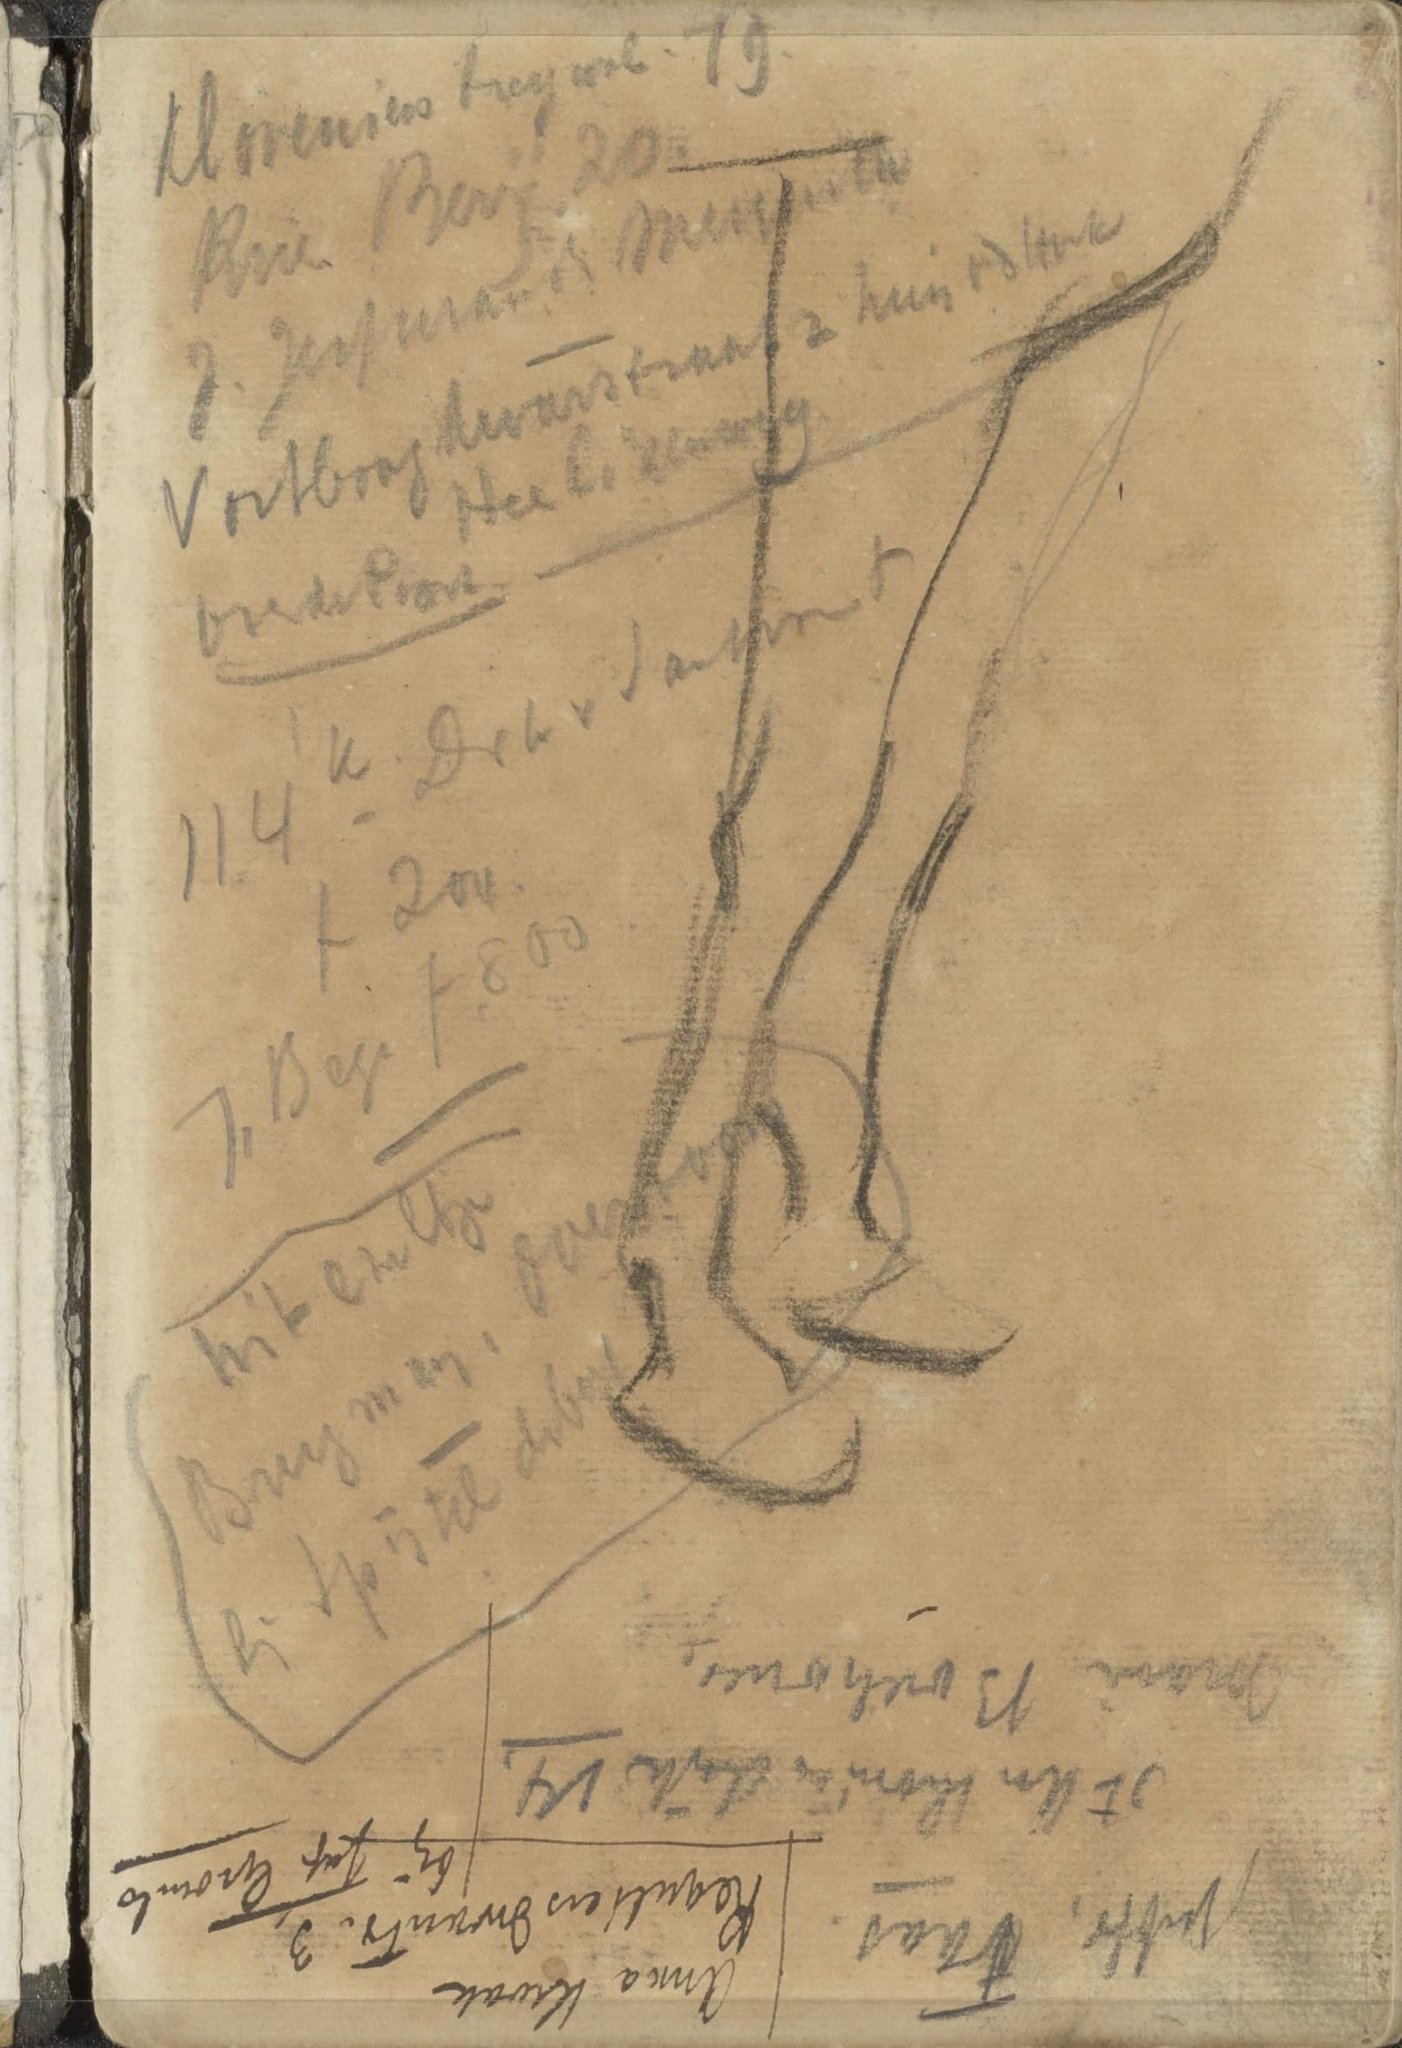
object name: sketchbook leaf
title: Achterbenen van een ezel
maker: george hendrik breitner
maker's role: draughtsman, painter, print maker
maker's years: 1857-1923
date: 1886-1923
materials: chalk, paper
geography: amsterdam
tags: ass, donkey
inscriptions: annotation: ‘Kooveniersburgwal 79./ Rue Bery 20./ [...]/ Voetboogdwarsstraat 2 huis od hoek/ [...]/ wit ezeltje/ Brugman, Overtoom/ [...]/ juffr. Faas/ [...]dijk 14/ [...]/ Anna Kwak/ Reguliersdwarsstr. 3./ bij juf. Groenlo’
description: Pagina 2 uit een schetsboek met 14 bladen.